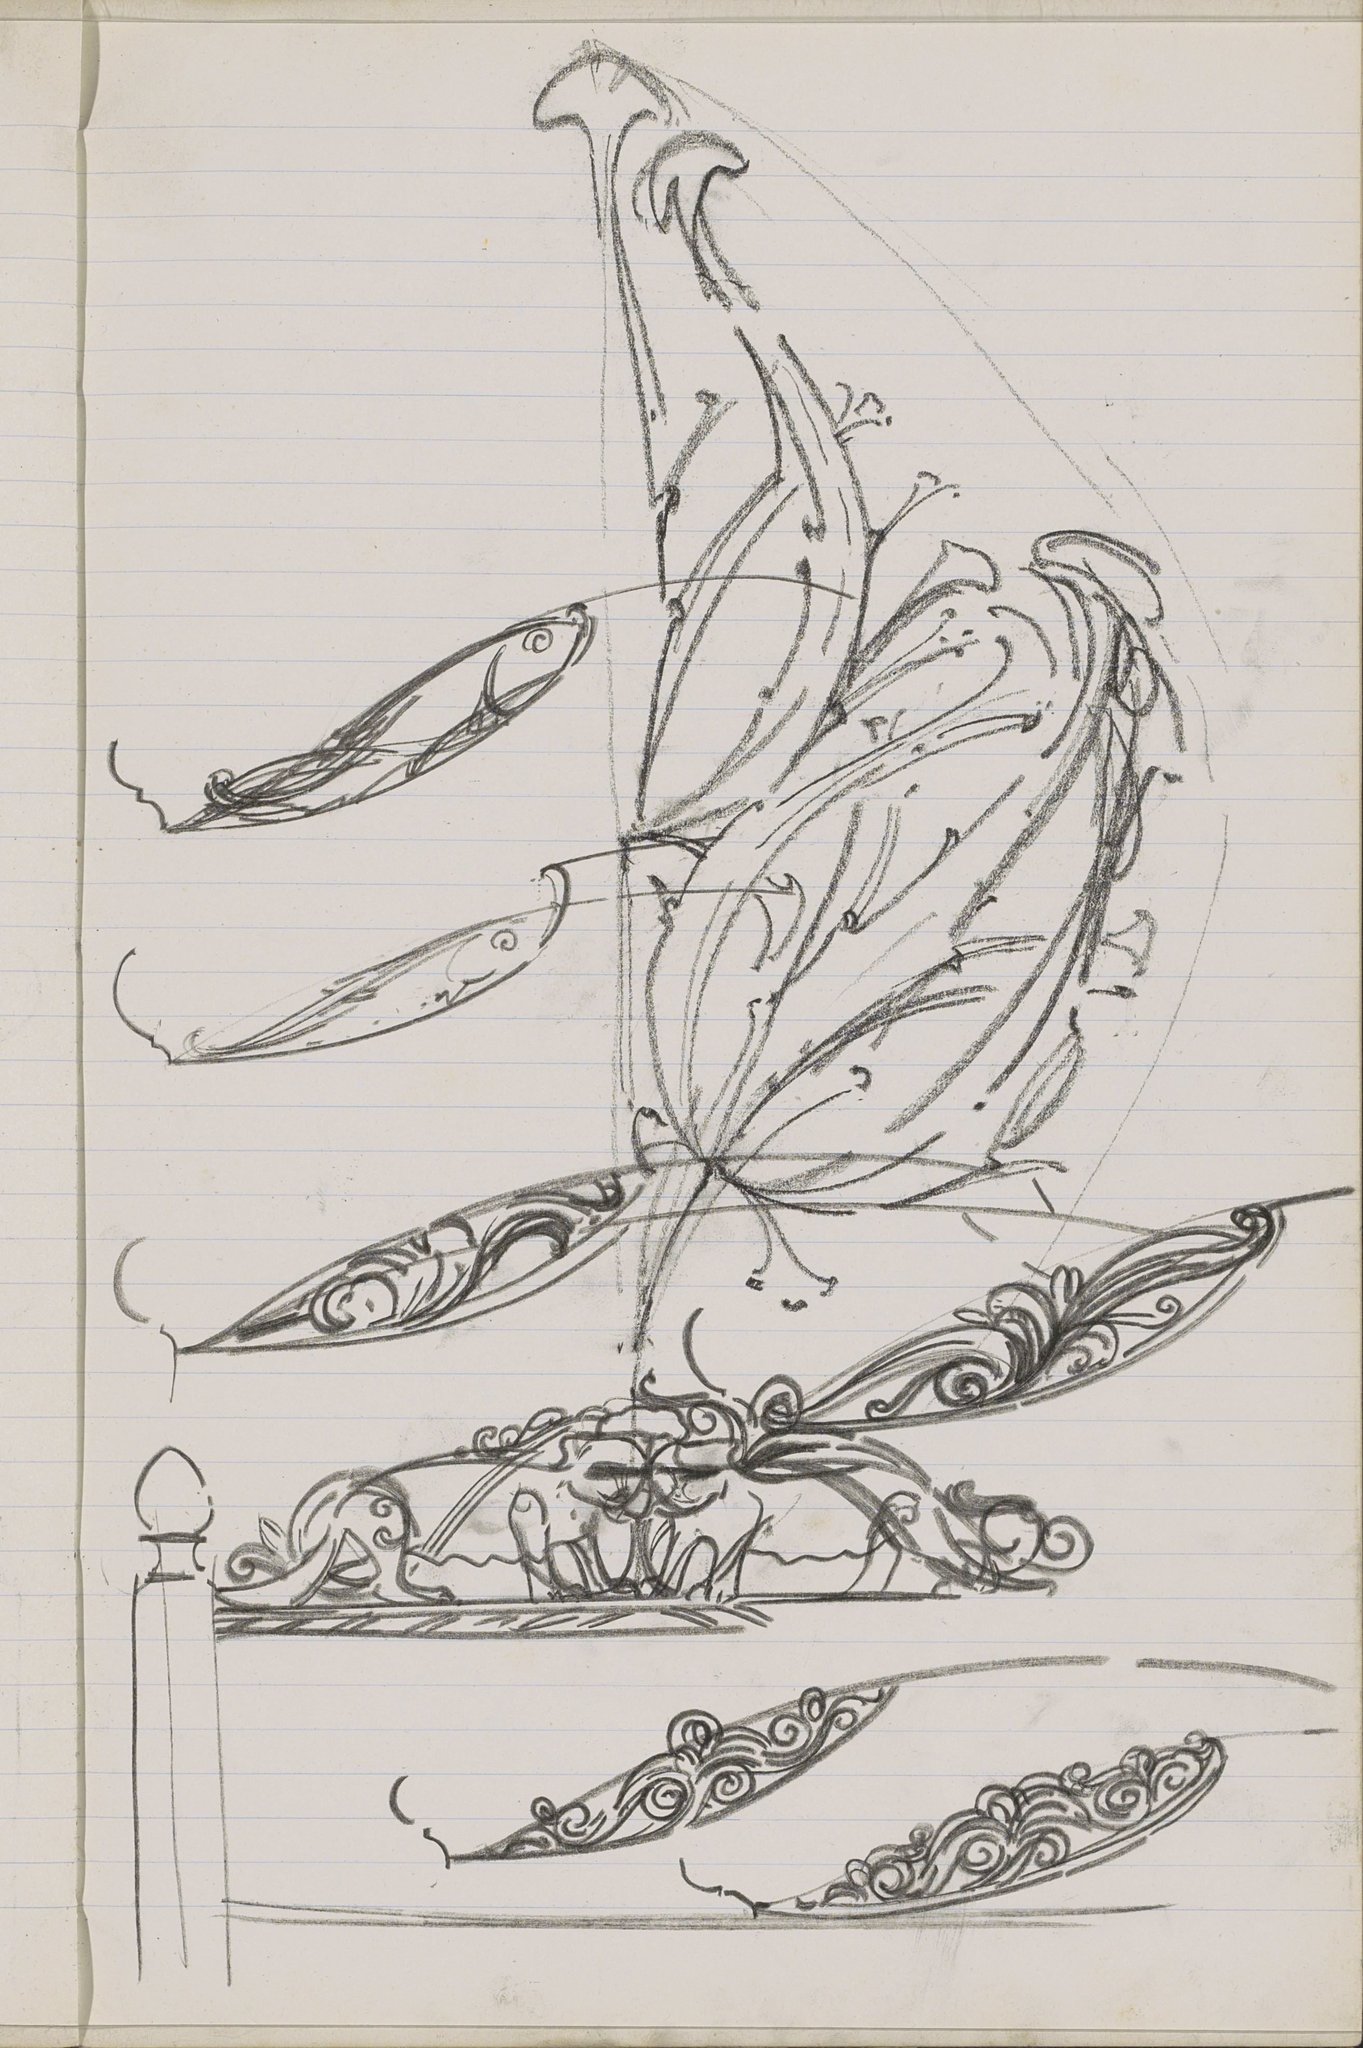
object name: sketchbook leaf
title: Ornamenten, op vlinders geïnspireerd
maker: gerrit willem dijsselhof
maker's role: designer, draughtsman, print maker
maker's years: 1866-1924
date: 1901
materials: chalk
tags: ornaments ~ art, insects: butterfly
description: Blad 53 recto uit een schetsboek met 79 bladen.